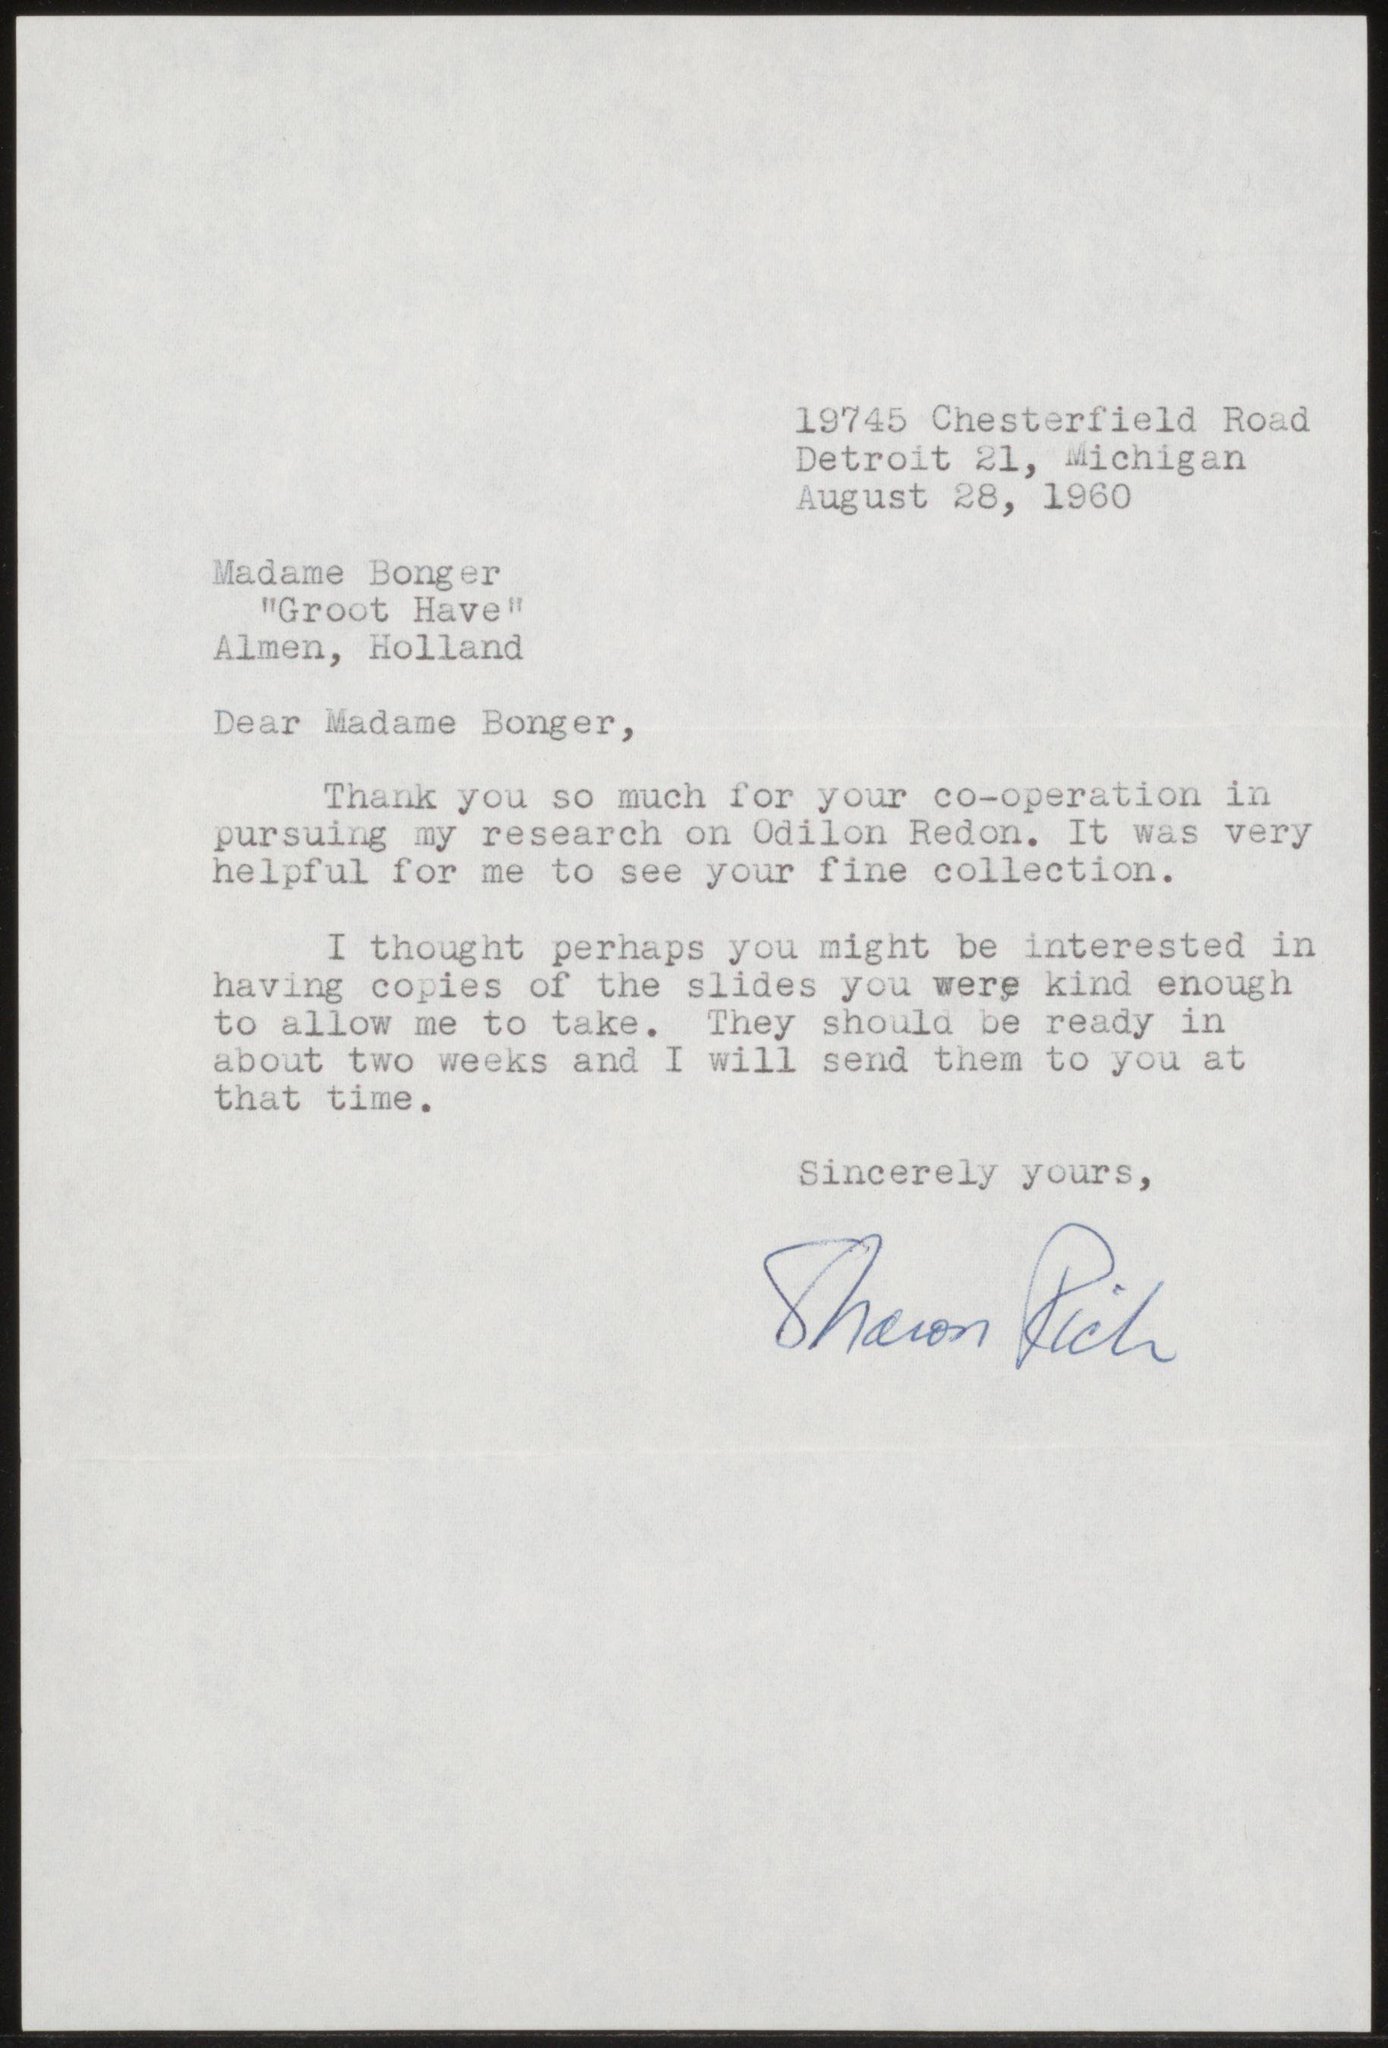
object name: letter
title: Brief aan Françoise W.M. Bonger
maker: sharon rich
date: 1960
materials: ink, paper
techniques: pen, typewriting, writing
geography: detroit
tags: paris, print maker, draughtsman, odilon redon, françoise w.m. bonger